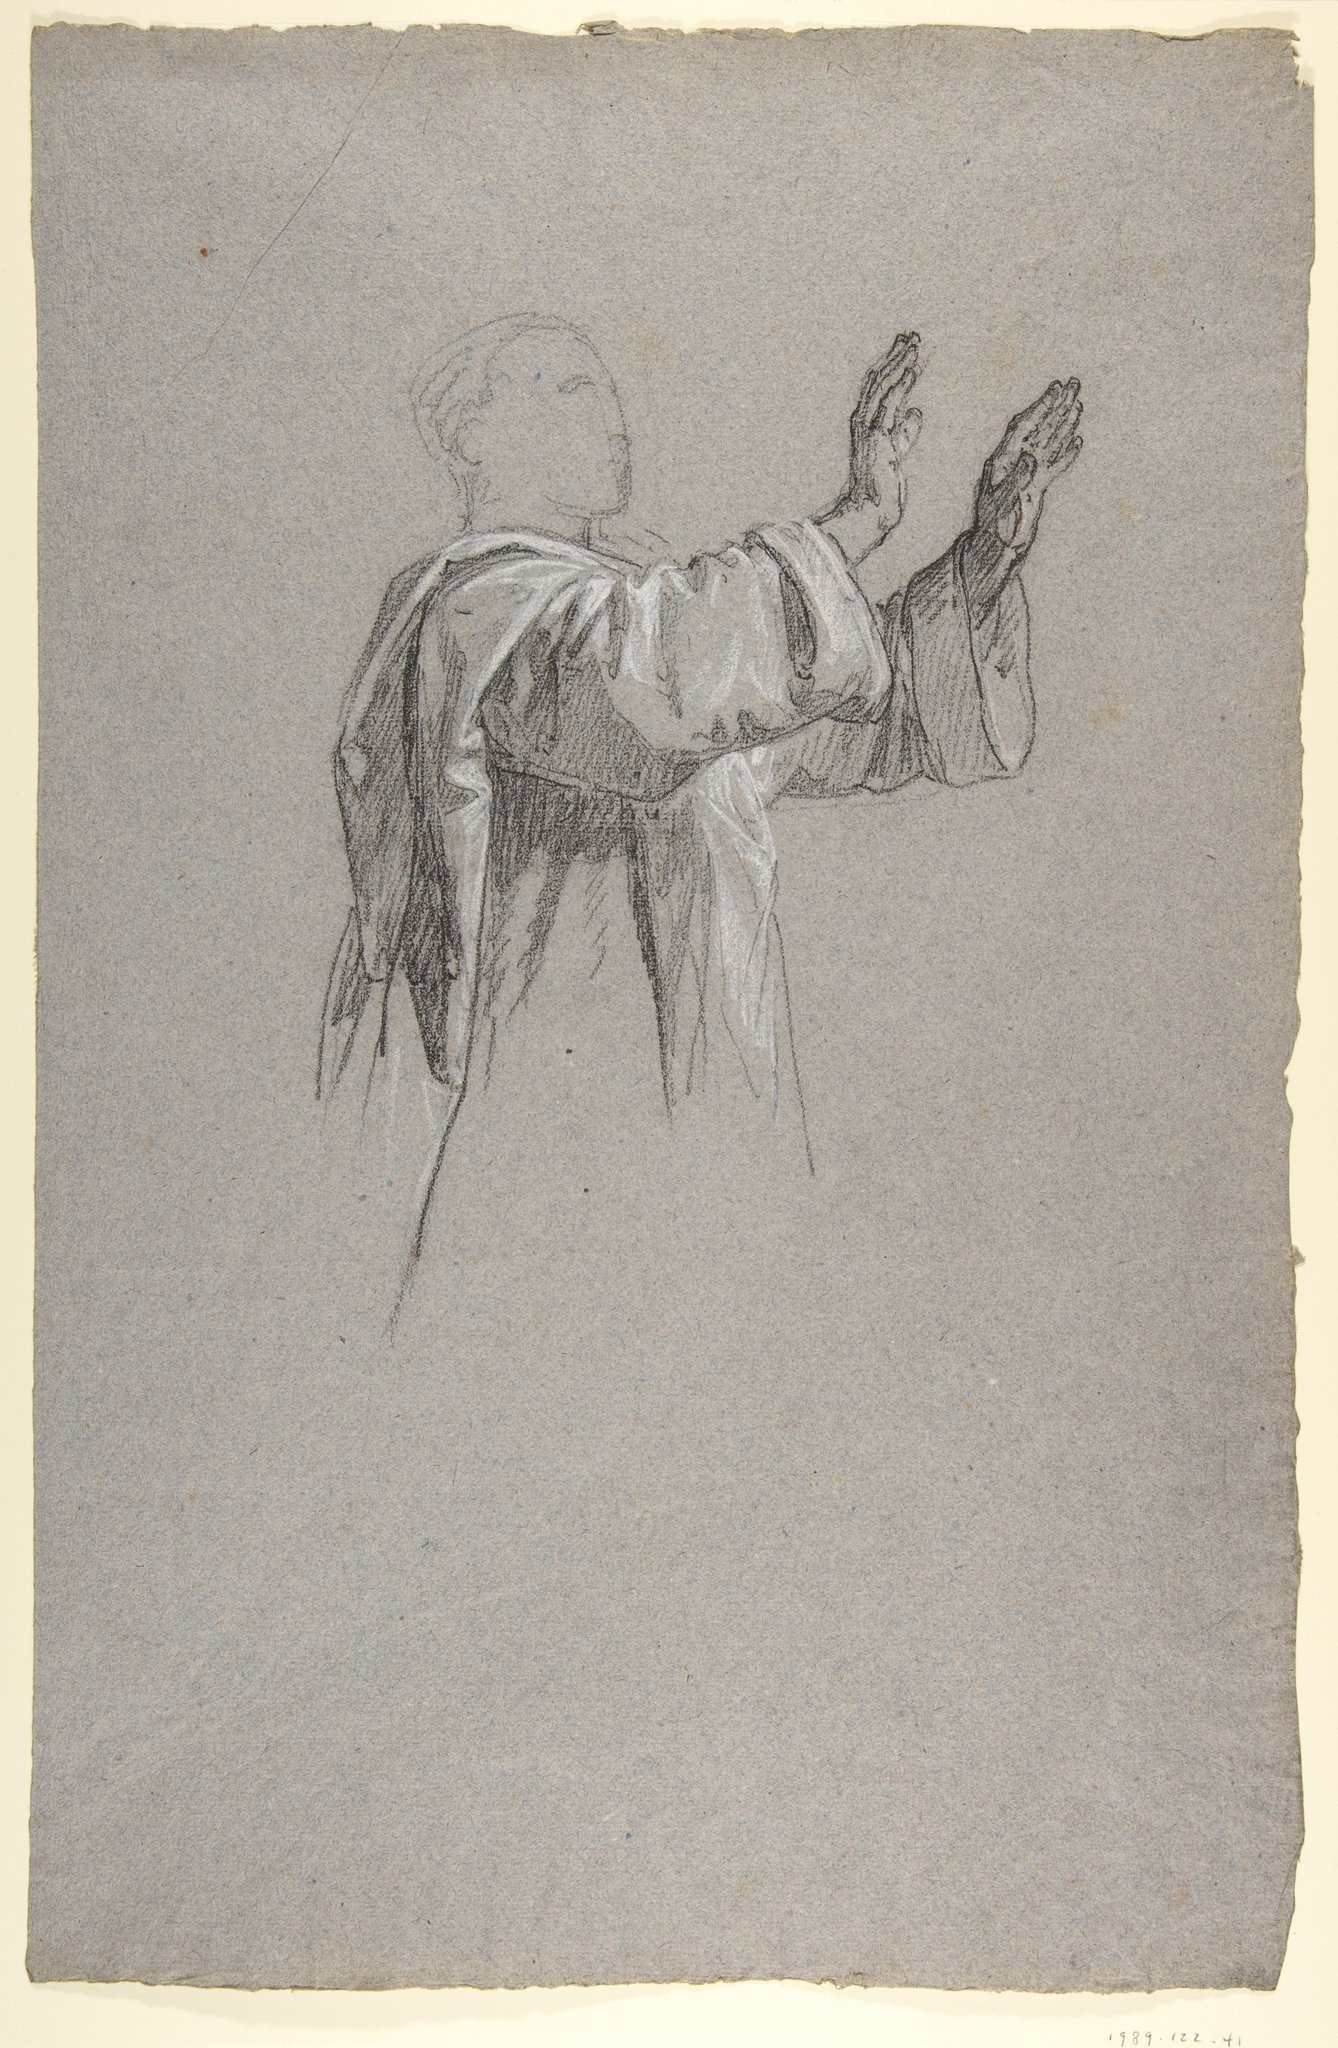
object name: drawing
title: Cleric with Raised Arms (lower register?; study for wall paintings in the Chapel of Saint Remi, Sainte-Clotilde, Paris, 1858)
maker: isidore pils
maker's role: artist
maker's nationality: french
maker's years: 1813-1875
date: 1801-1900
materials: chalk, paper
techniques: heightening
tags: hands,men